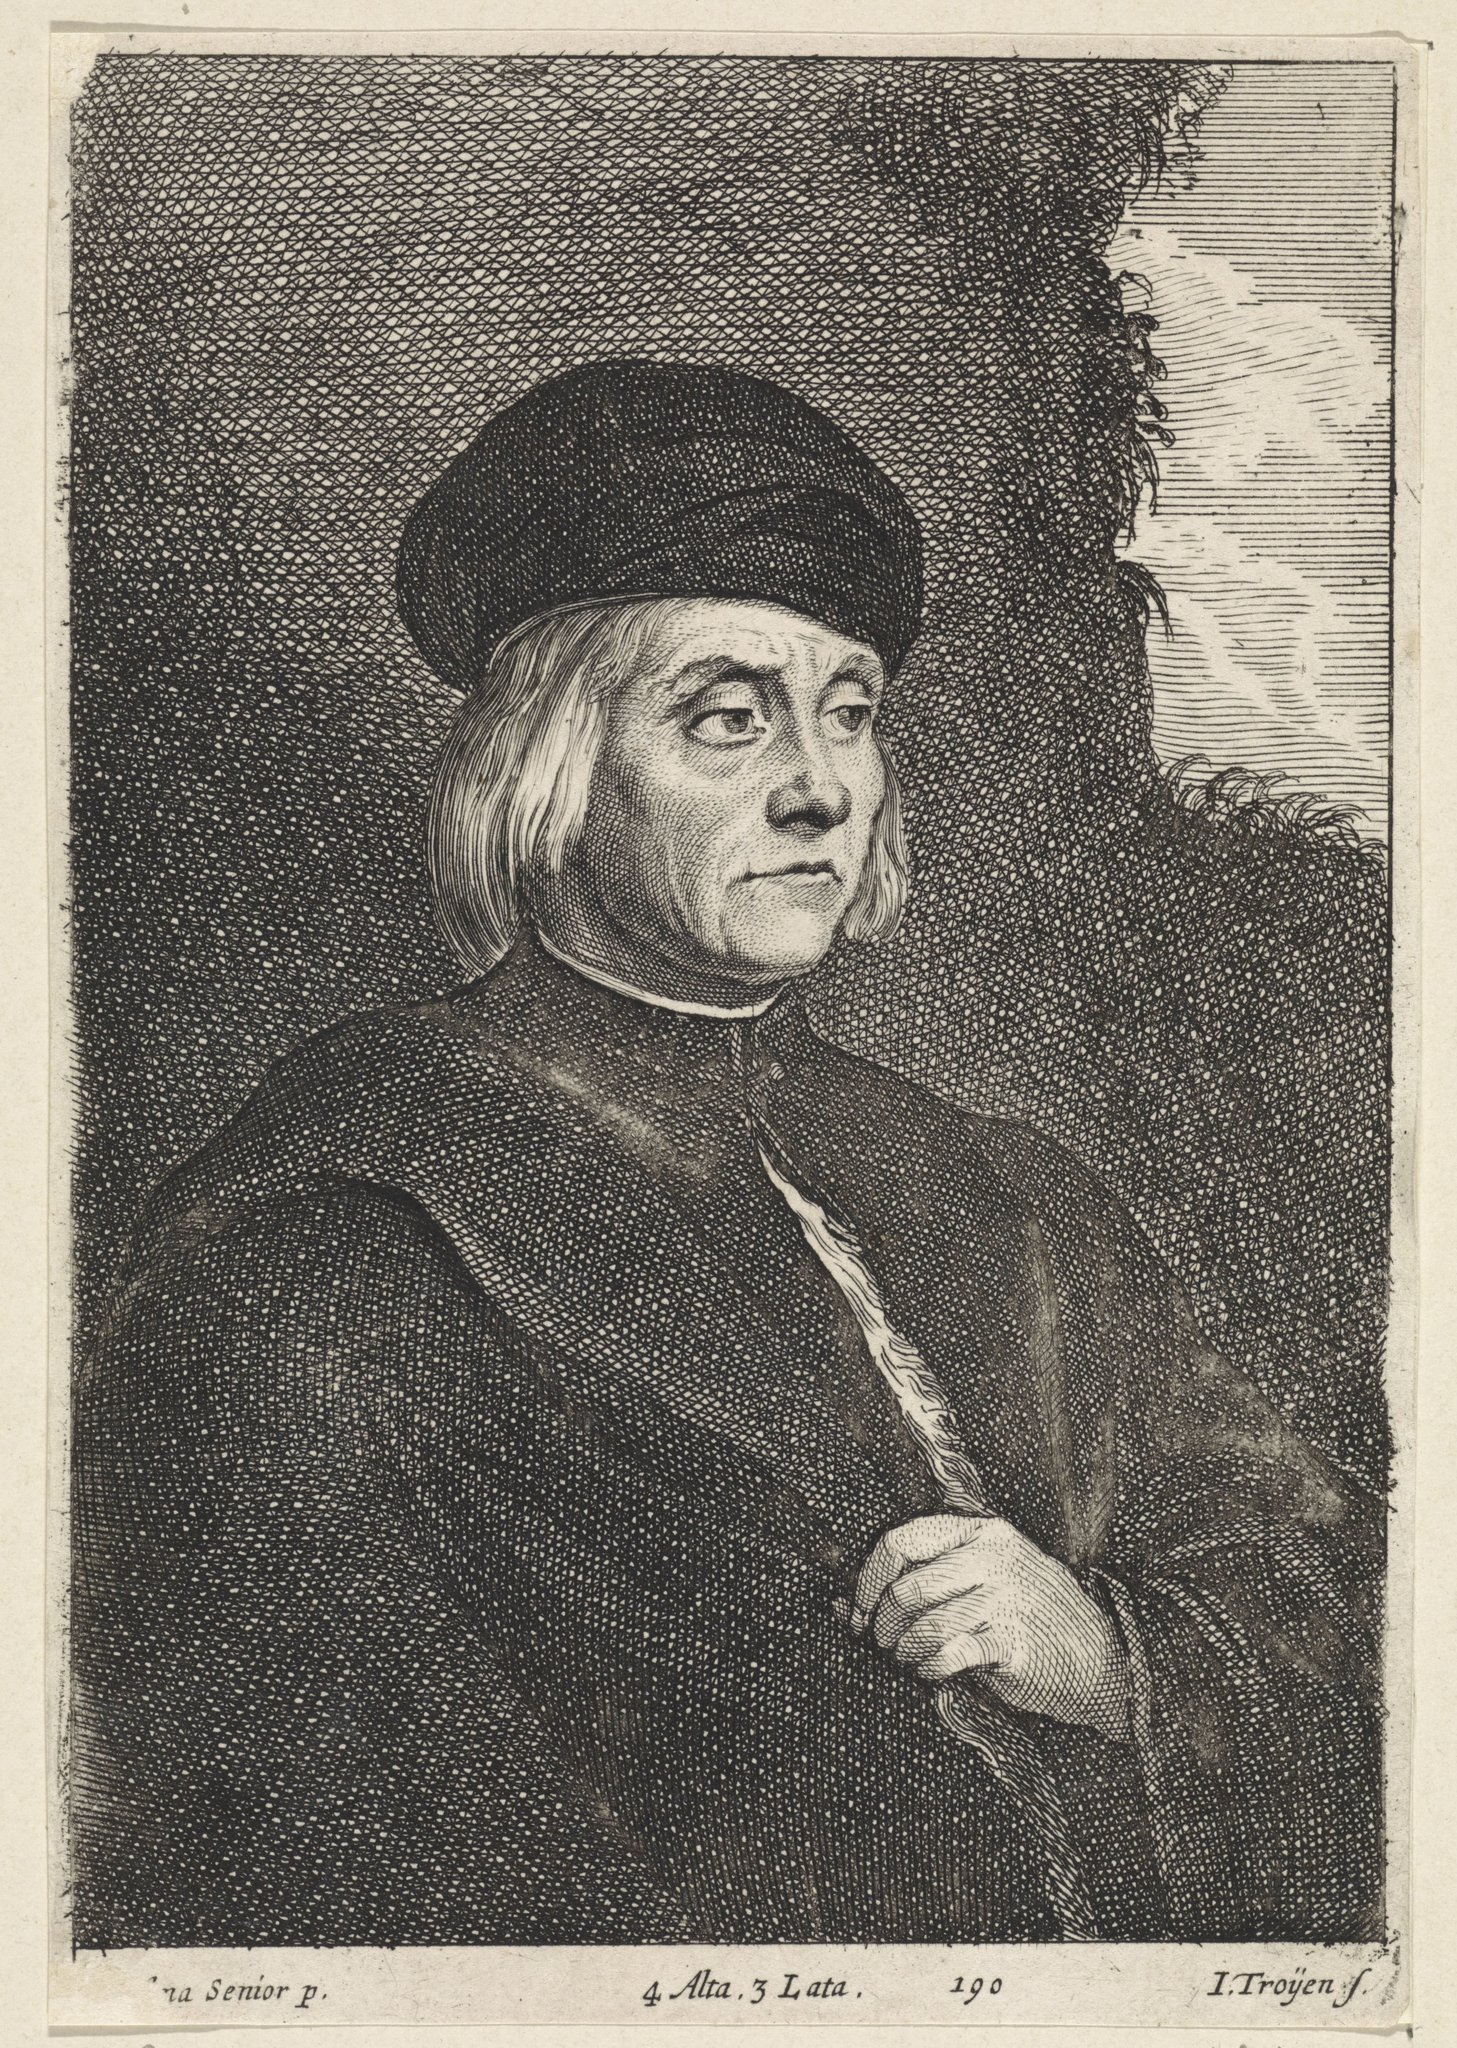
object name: print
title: Portret van een onbekende man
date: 1673-1700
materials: paper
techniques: engraving, etching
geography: brussels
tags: head-gear: cap (+ men's clothes)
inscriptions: collector's mark: Lugt 2228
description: Prent uit deze of een latere editie van: Teniers, David. Schilder-Thoneel ... in 't welck vertoont worden Italiaensche principale Schilderijen ... die hy ... gheteeckent ende in 't coper doen snijden heeft uyt de Schilder-Camer van den ... Arts-hertogh [Leopold Wilhelm] in 't Hoff van Brussel. 2de druk. Antwerpen 1673.